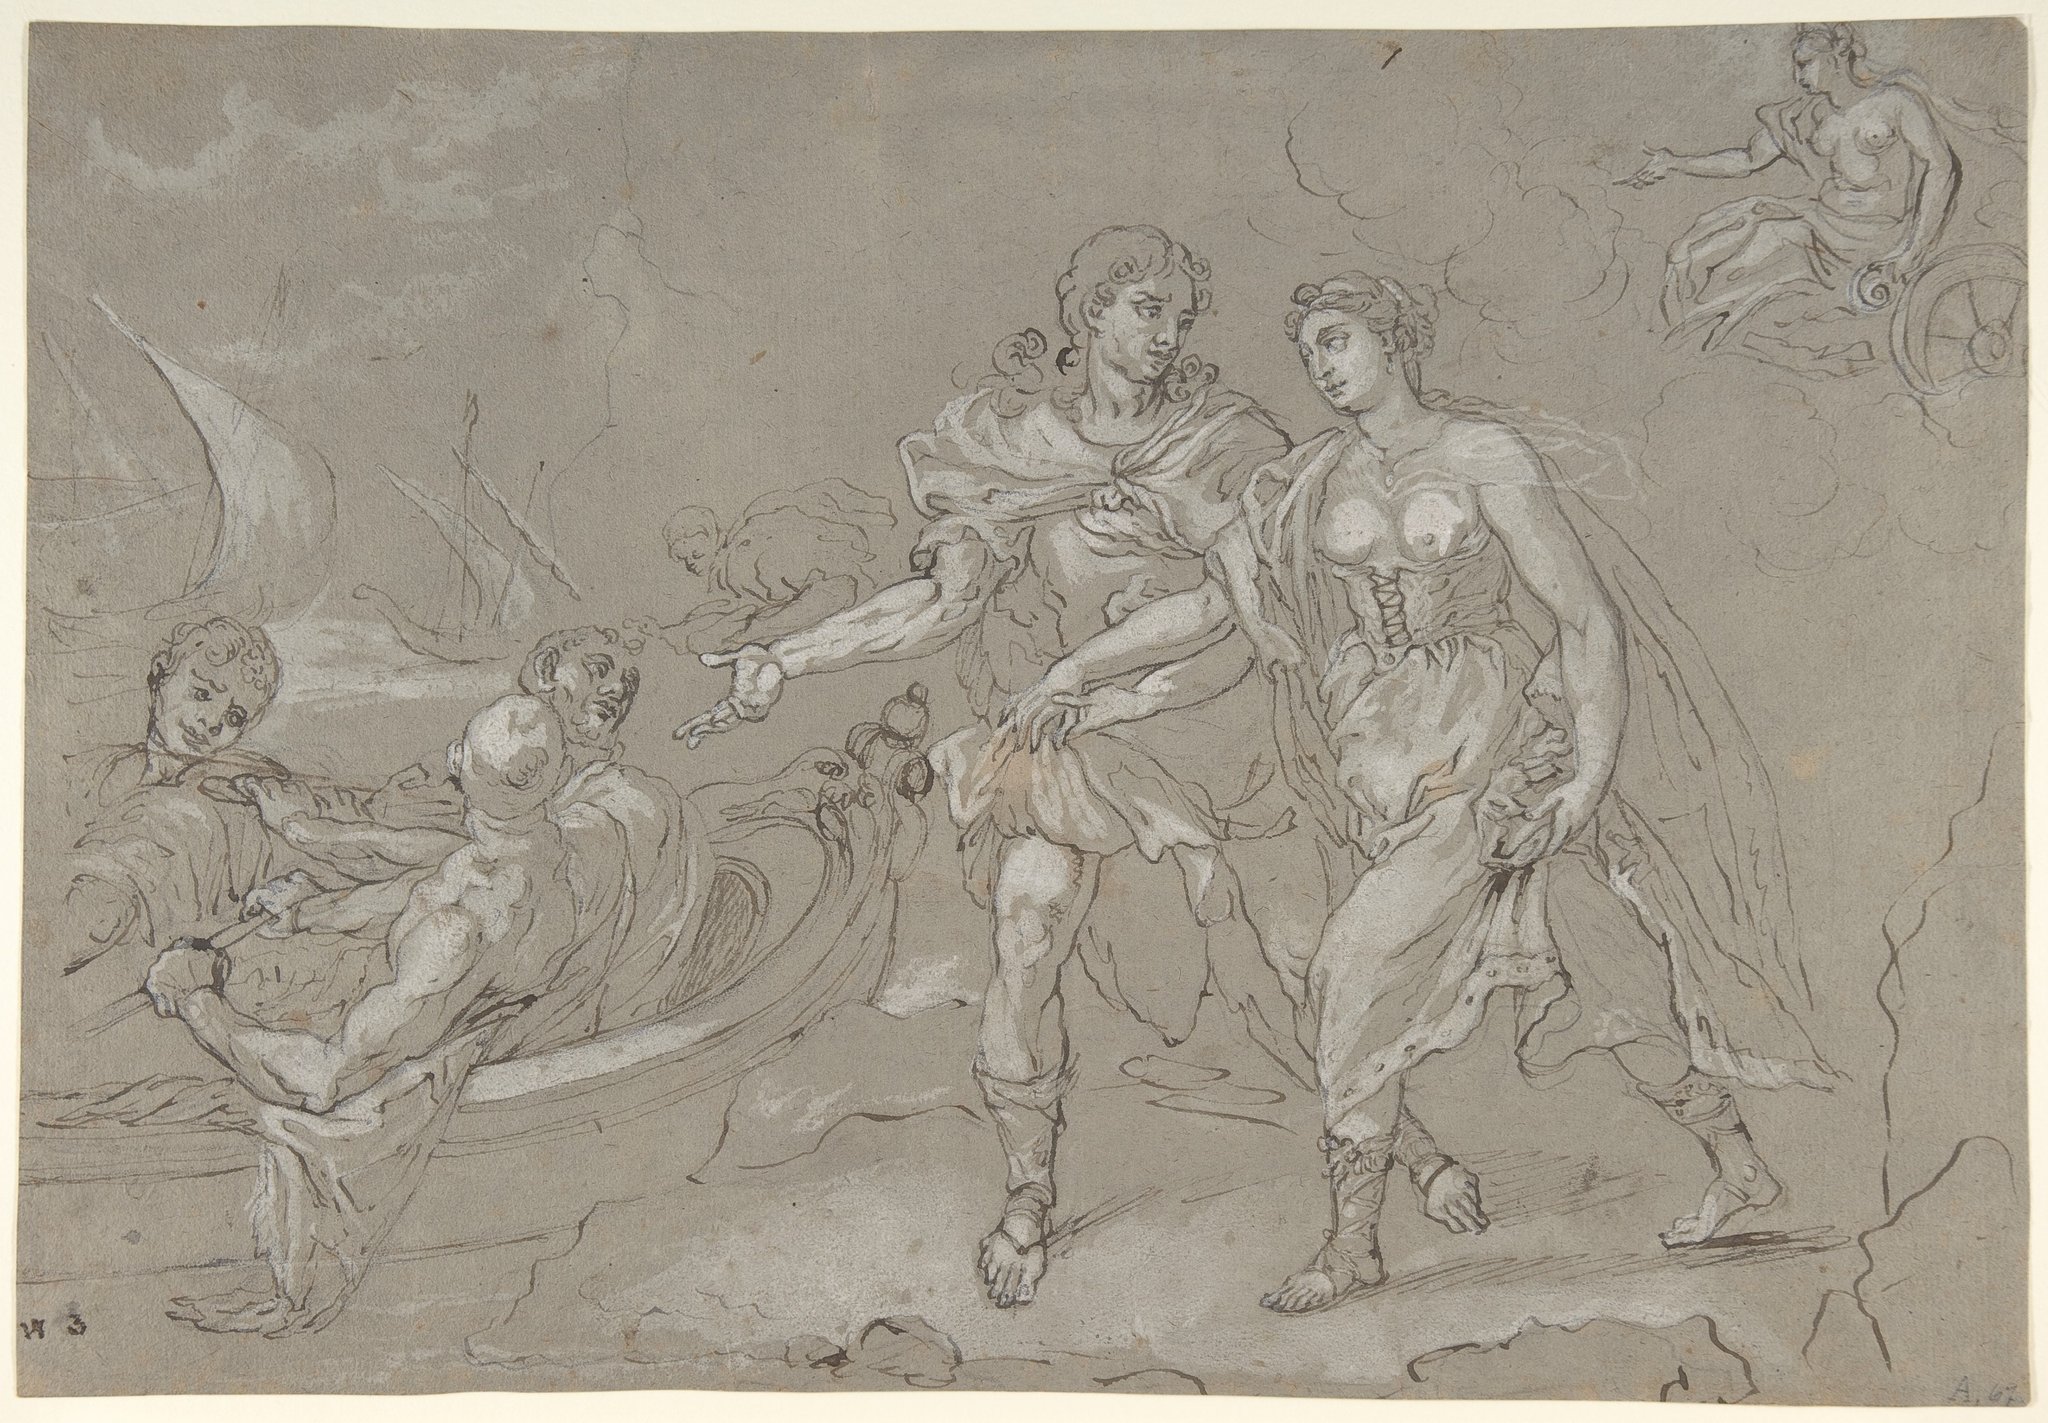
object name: drawing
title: The Rape of Helena; verso: Study of a Kneeling Nude Male Figure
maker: daniel seiter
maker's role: artist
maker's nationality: austrian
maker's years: 1647-1705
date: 1667-1800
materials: chalk, ink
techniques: heightening, pen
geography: austria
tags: men,male nudes,female nudes,boats